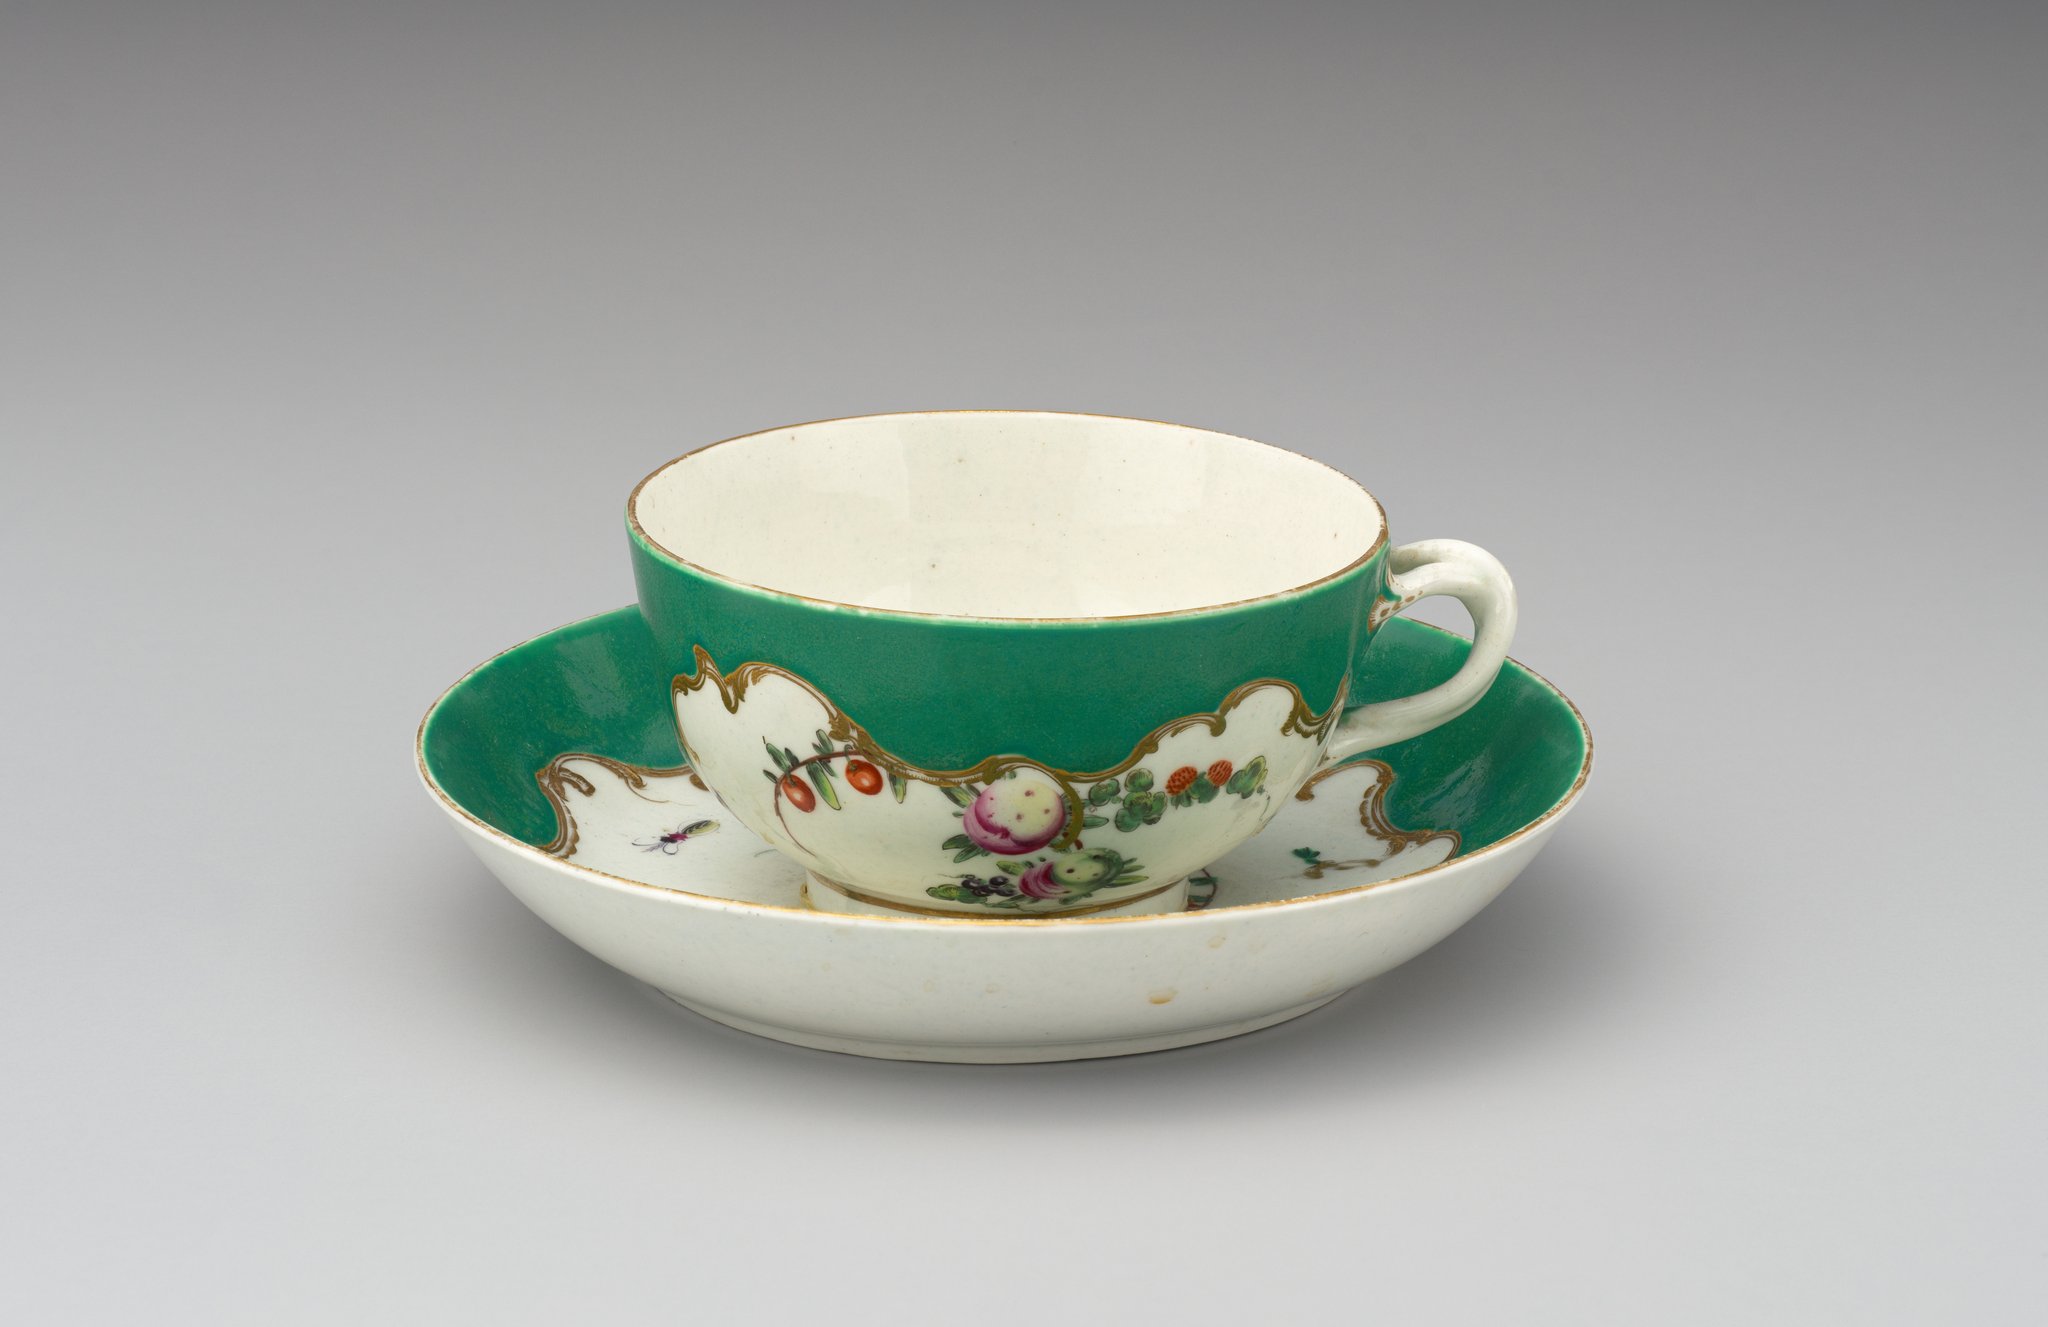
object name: saucer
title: Saucer (part of a service)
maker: worcester factory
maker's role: factory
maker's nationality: british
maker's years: 1751-2008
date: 1770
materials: soft paste porcelain